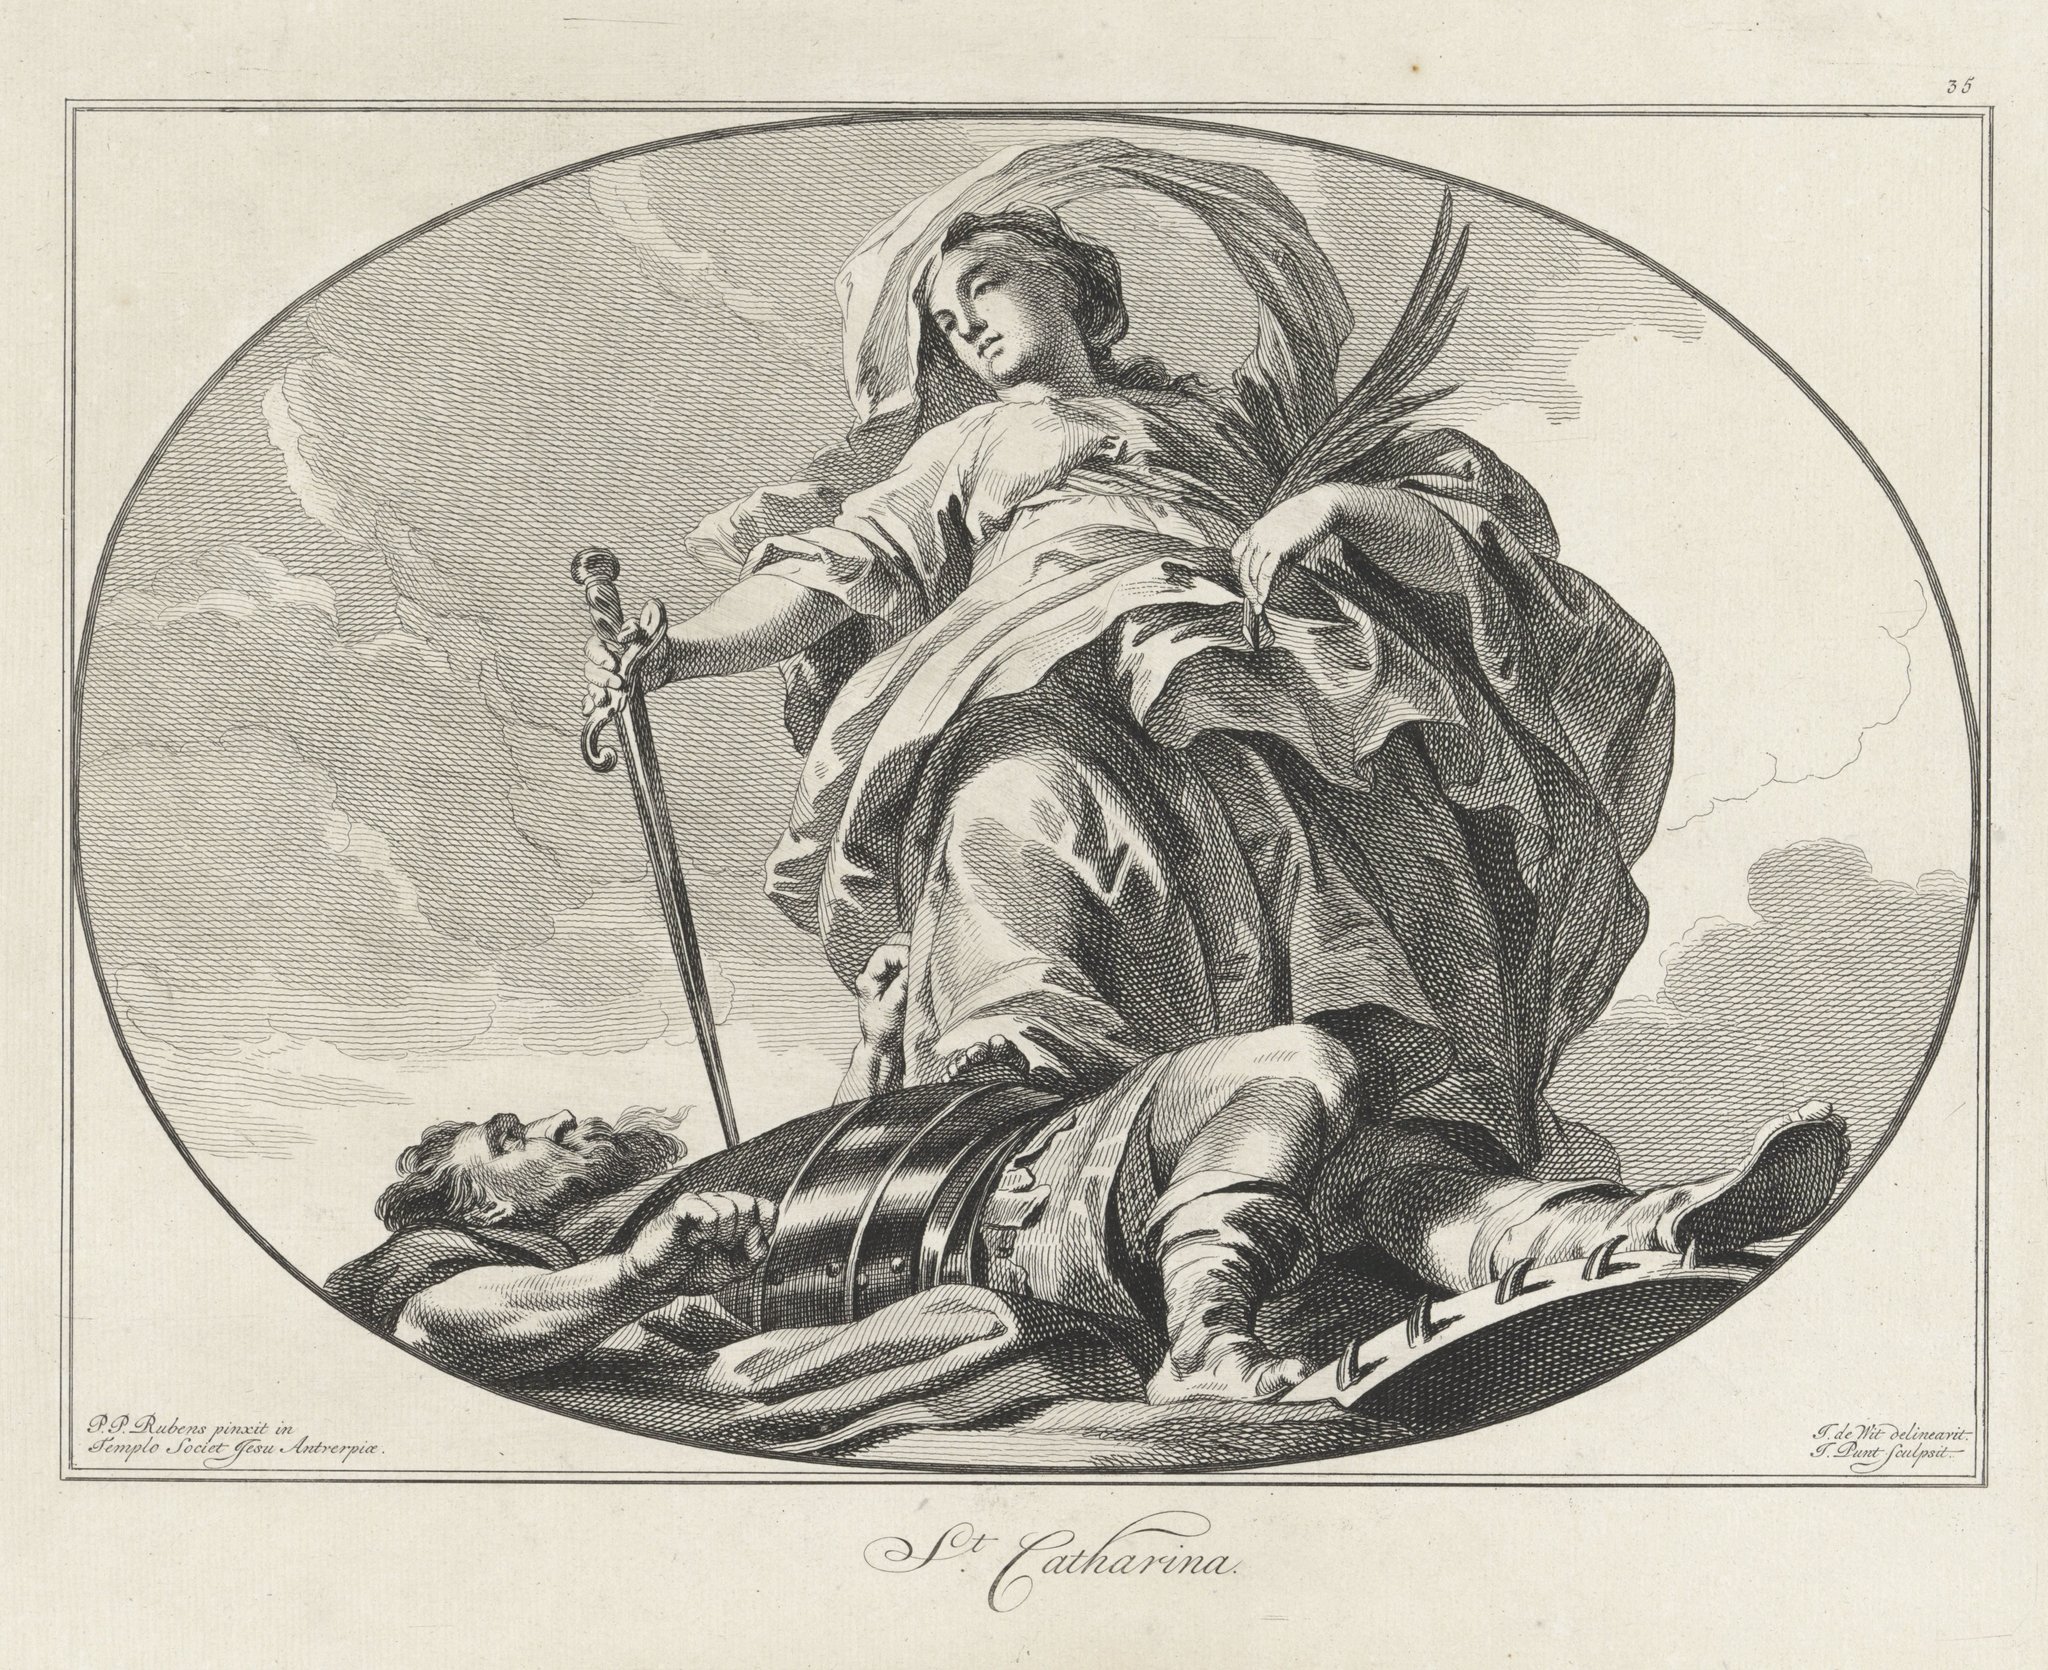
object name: print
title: H. Catharina van Alexandrië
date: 1751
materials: paper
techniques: engraving, etching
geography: amsterdam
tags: the virgin martyr catherine of alexandria; possible attributes: book, crown, emperor maxentius, palm-branch, ring, sword, wheel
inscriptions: collector's mark: Lugt 240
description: De heilige Catharina van Alexandrië, met palmtak en zwaard in de handen. Keizer Maxentius en het gebroken wiel aan haar voeten. Onder de ovale voorstelling een opschrift in het Latijn.